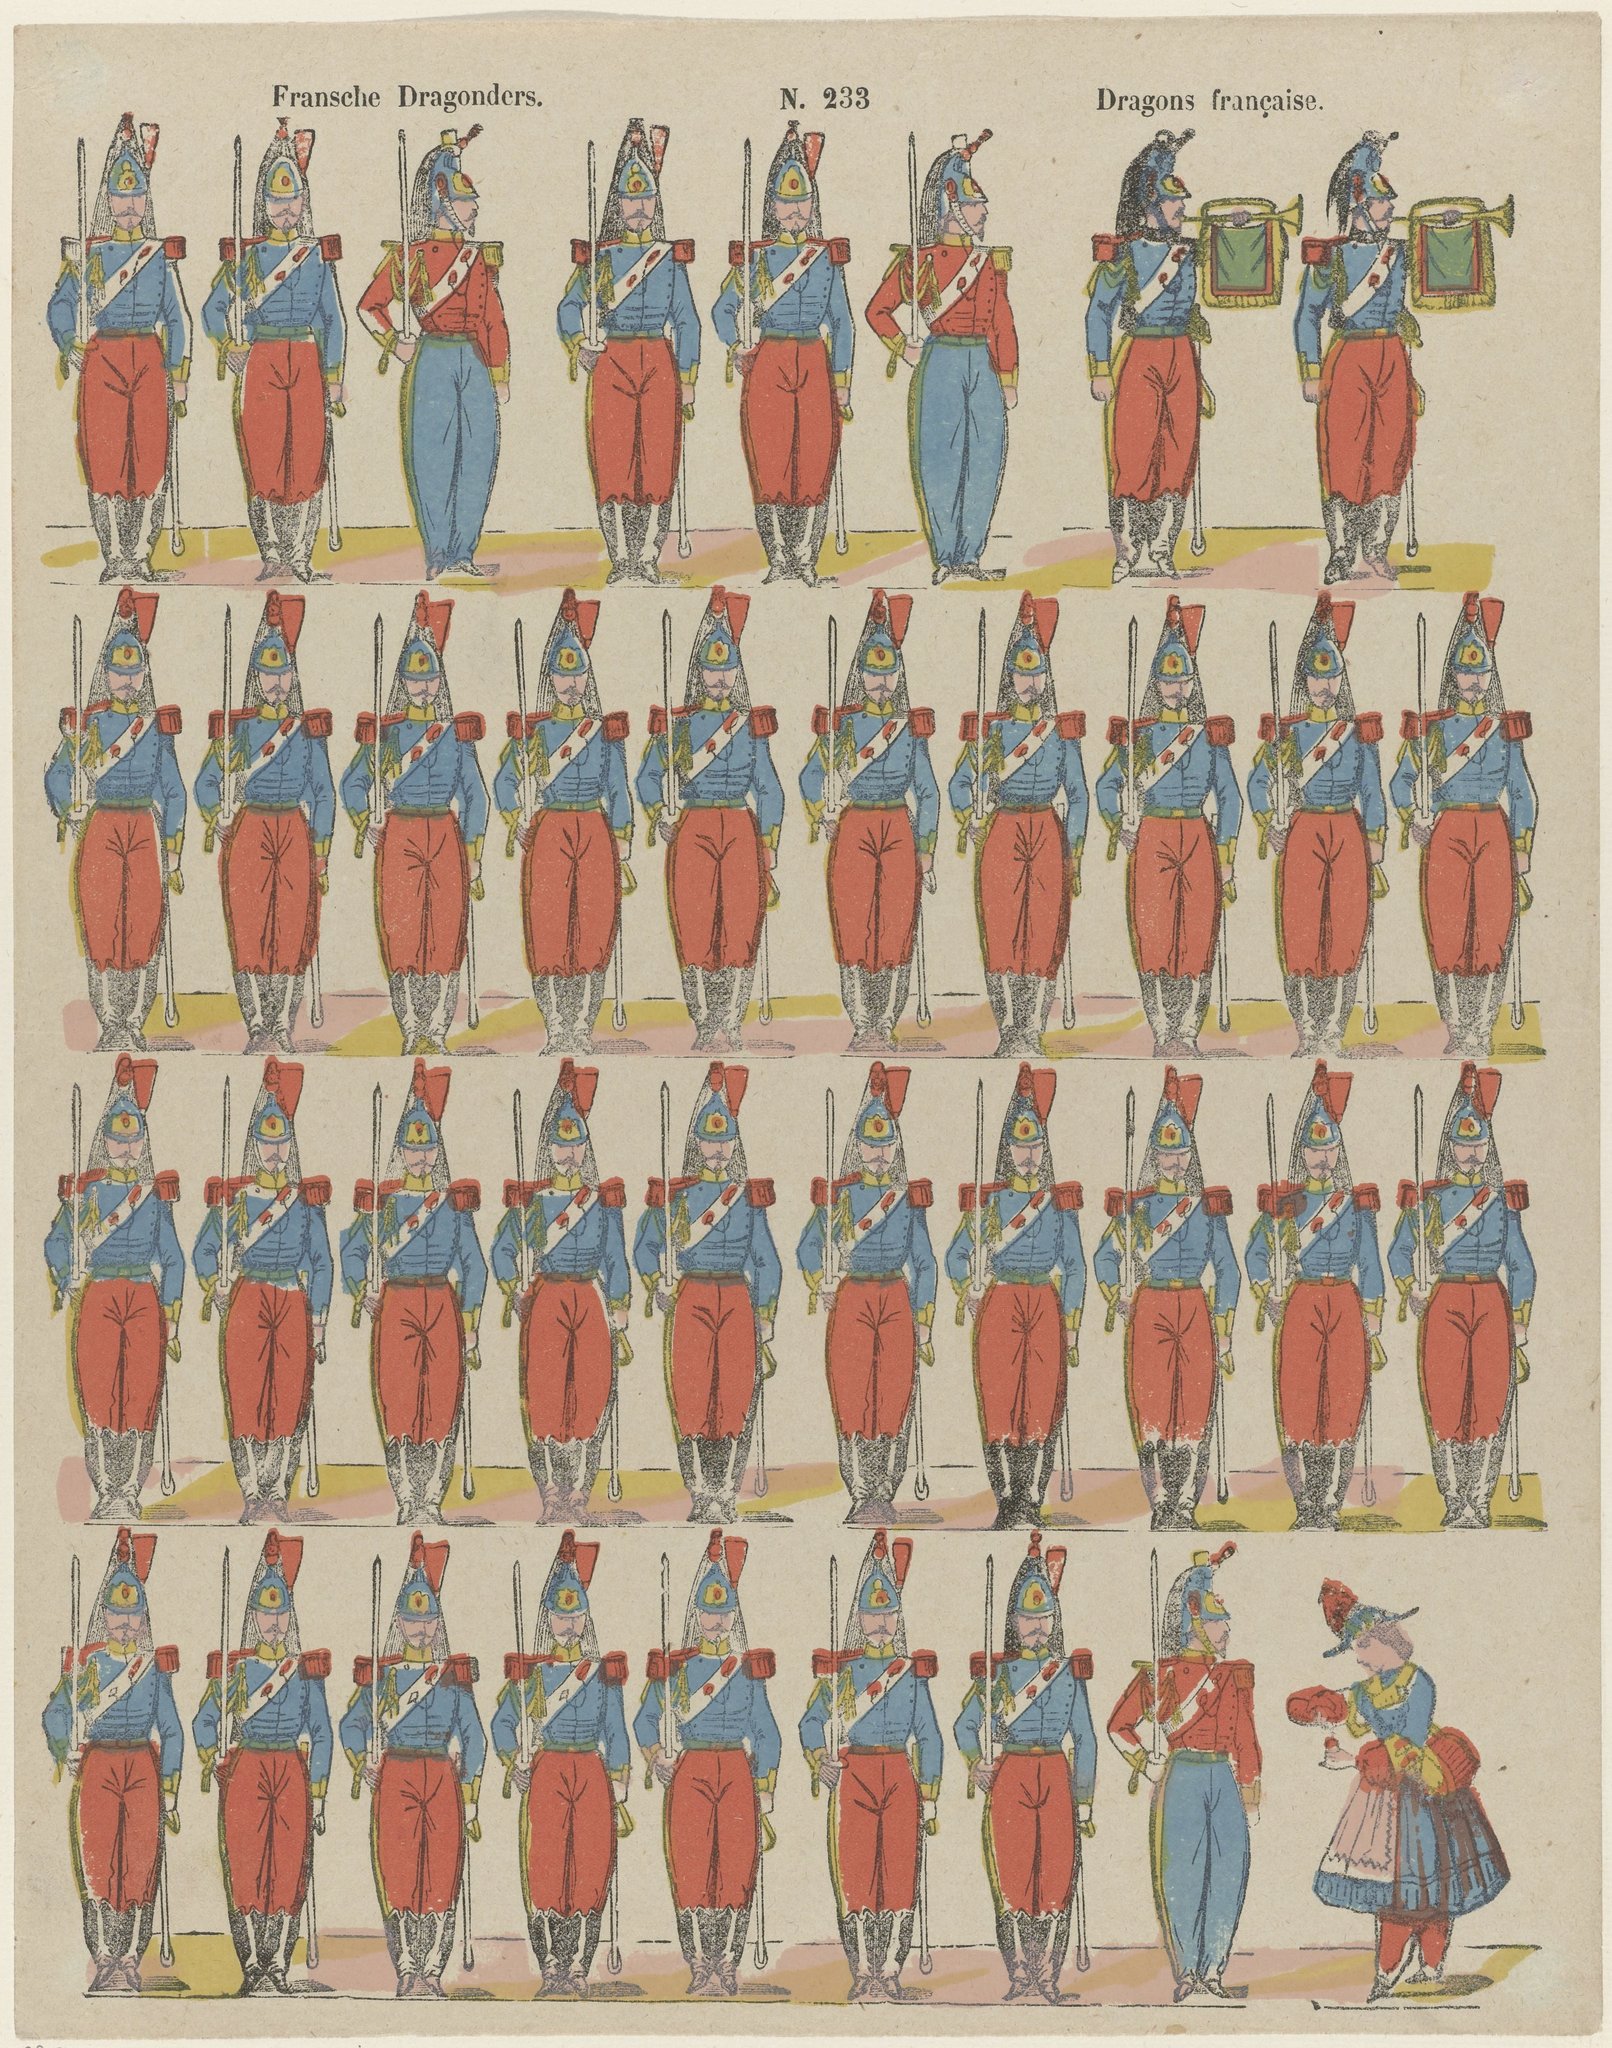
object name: popular print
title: Fransche dragonders / Dragons français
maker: Anonymous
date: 1833-1911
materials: paper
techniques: lithograph, letterpress printing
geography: turnhout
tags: the soldier; the soldier's life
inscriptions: collector's mark: Lugt 2760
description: Blad met 4 horizontale rijen met in totaal 37 voorstellingen van Franse militairen. Genummerd midden boven: N. 233.